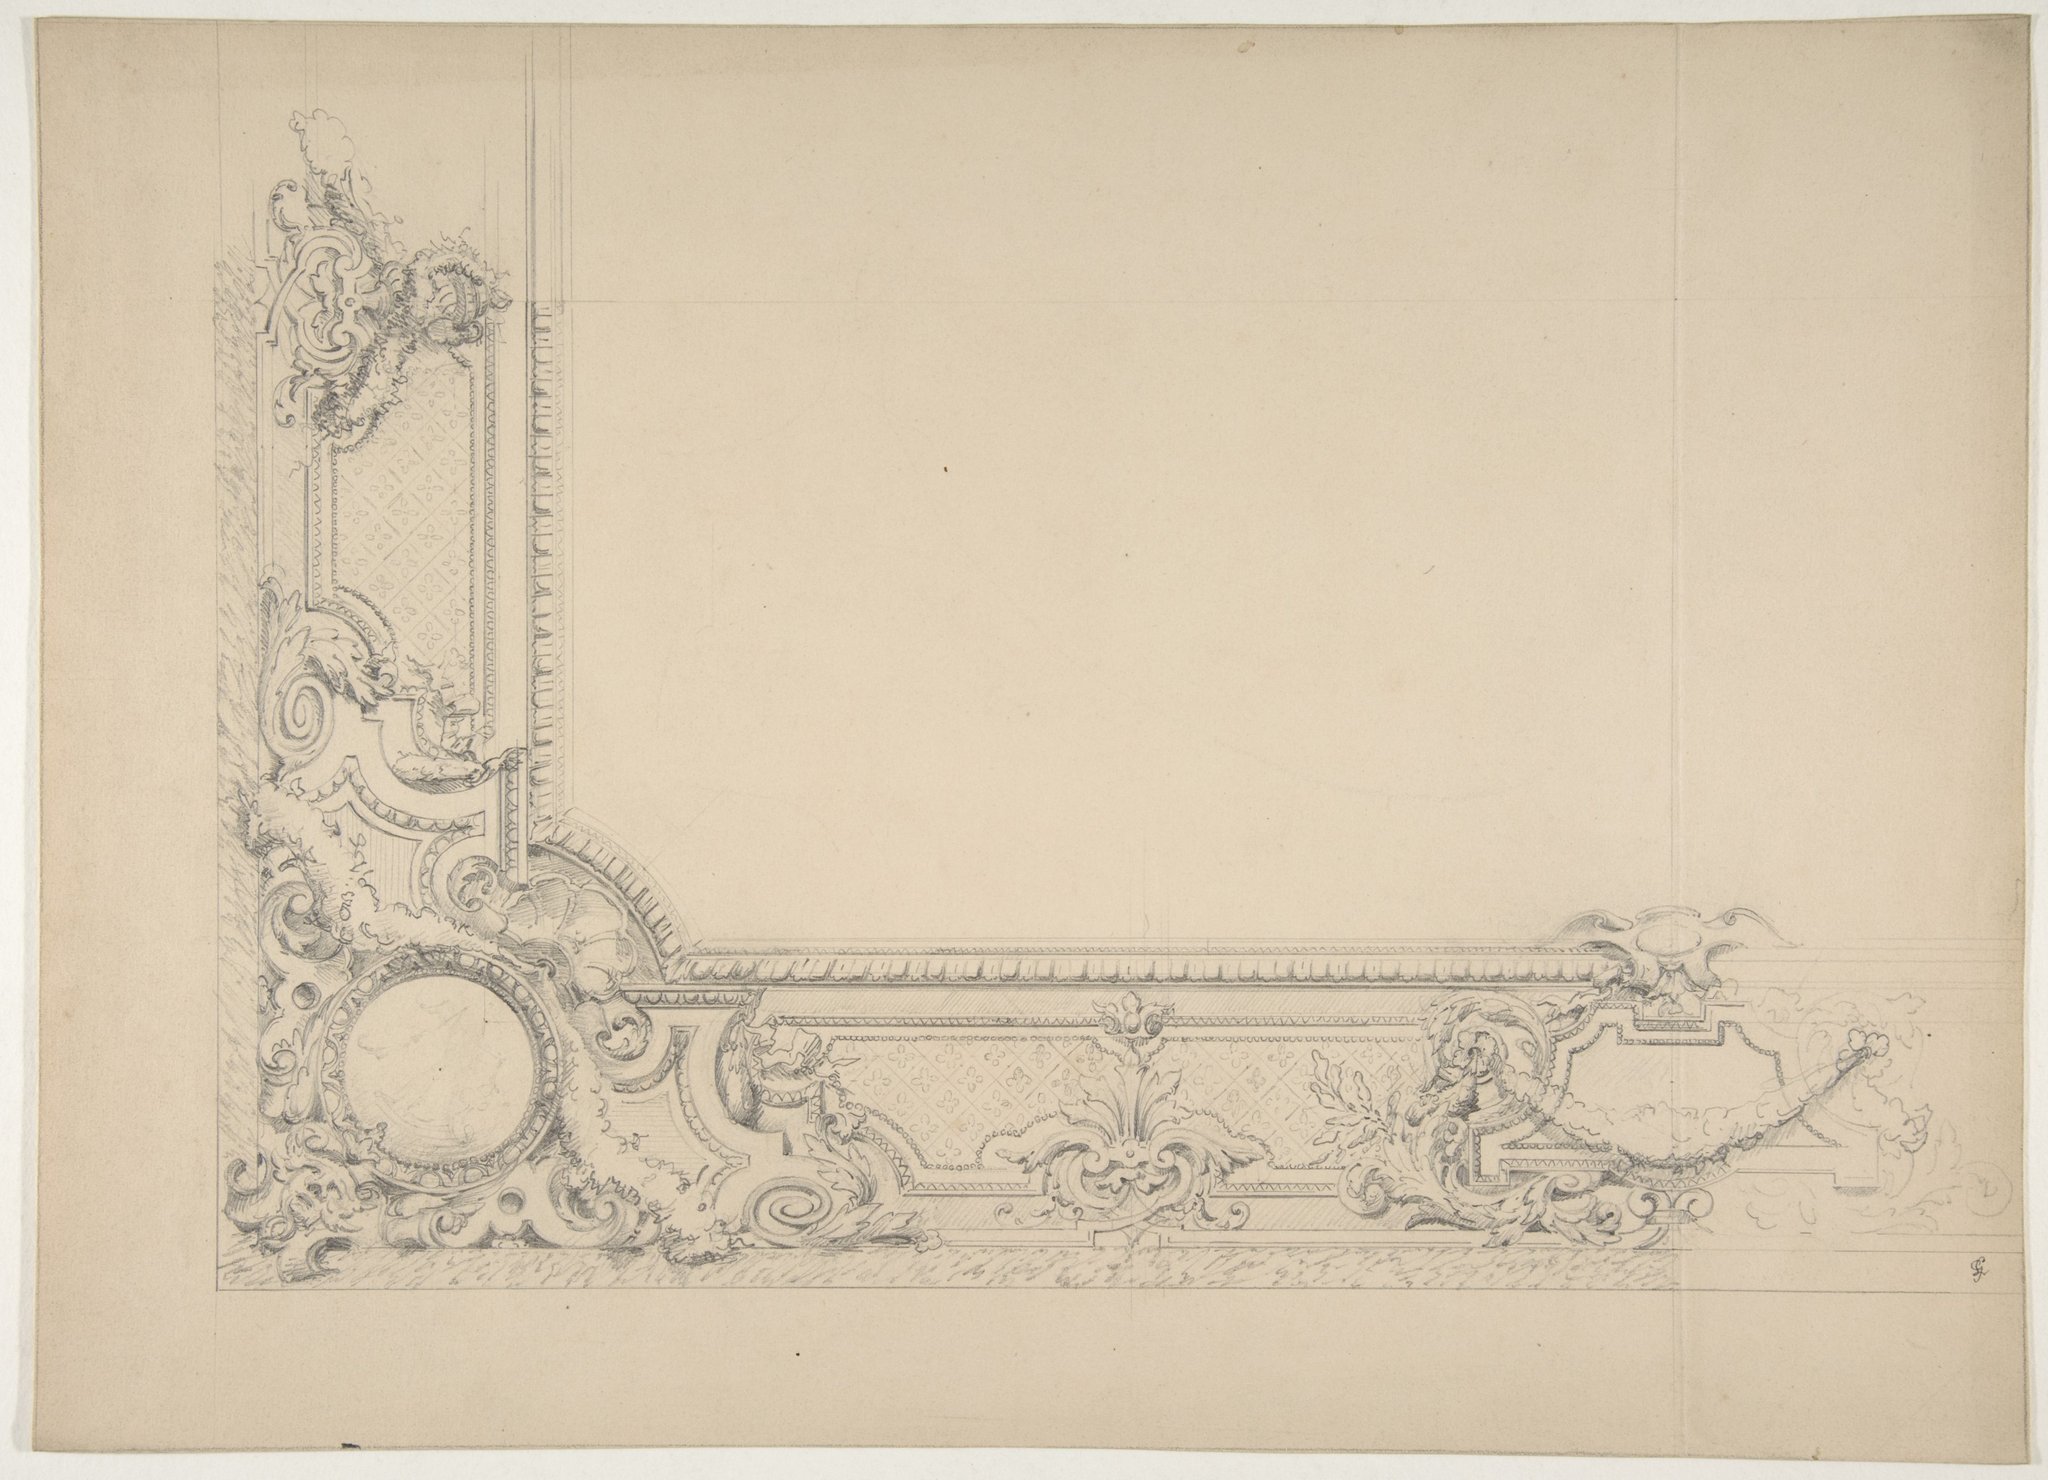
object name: drawing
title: Partial design for a ceiling with an ornate border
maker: jules-edmond-charles lachaise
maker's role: artist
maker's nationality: french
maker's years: 1897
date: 1830-1897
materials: graphite, paper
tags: ceilings